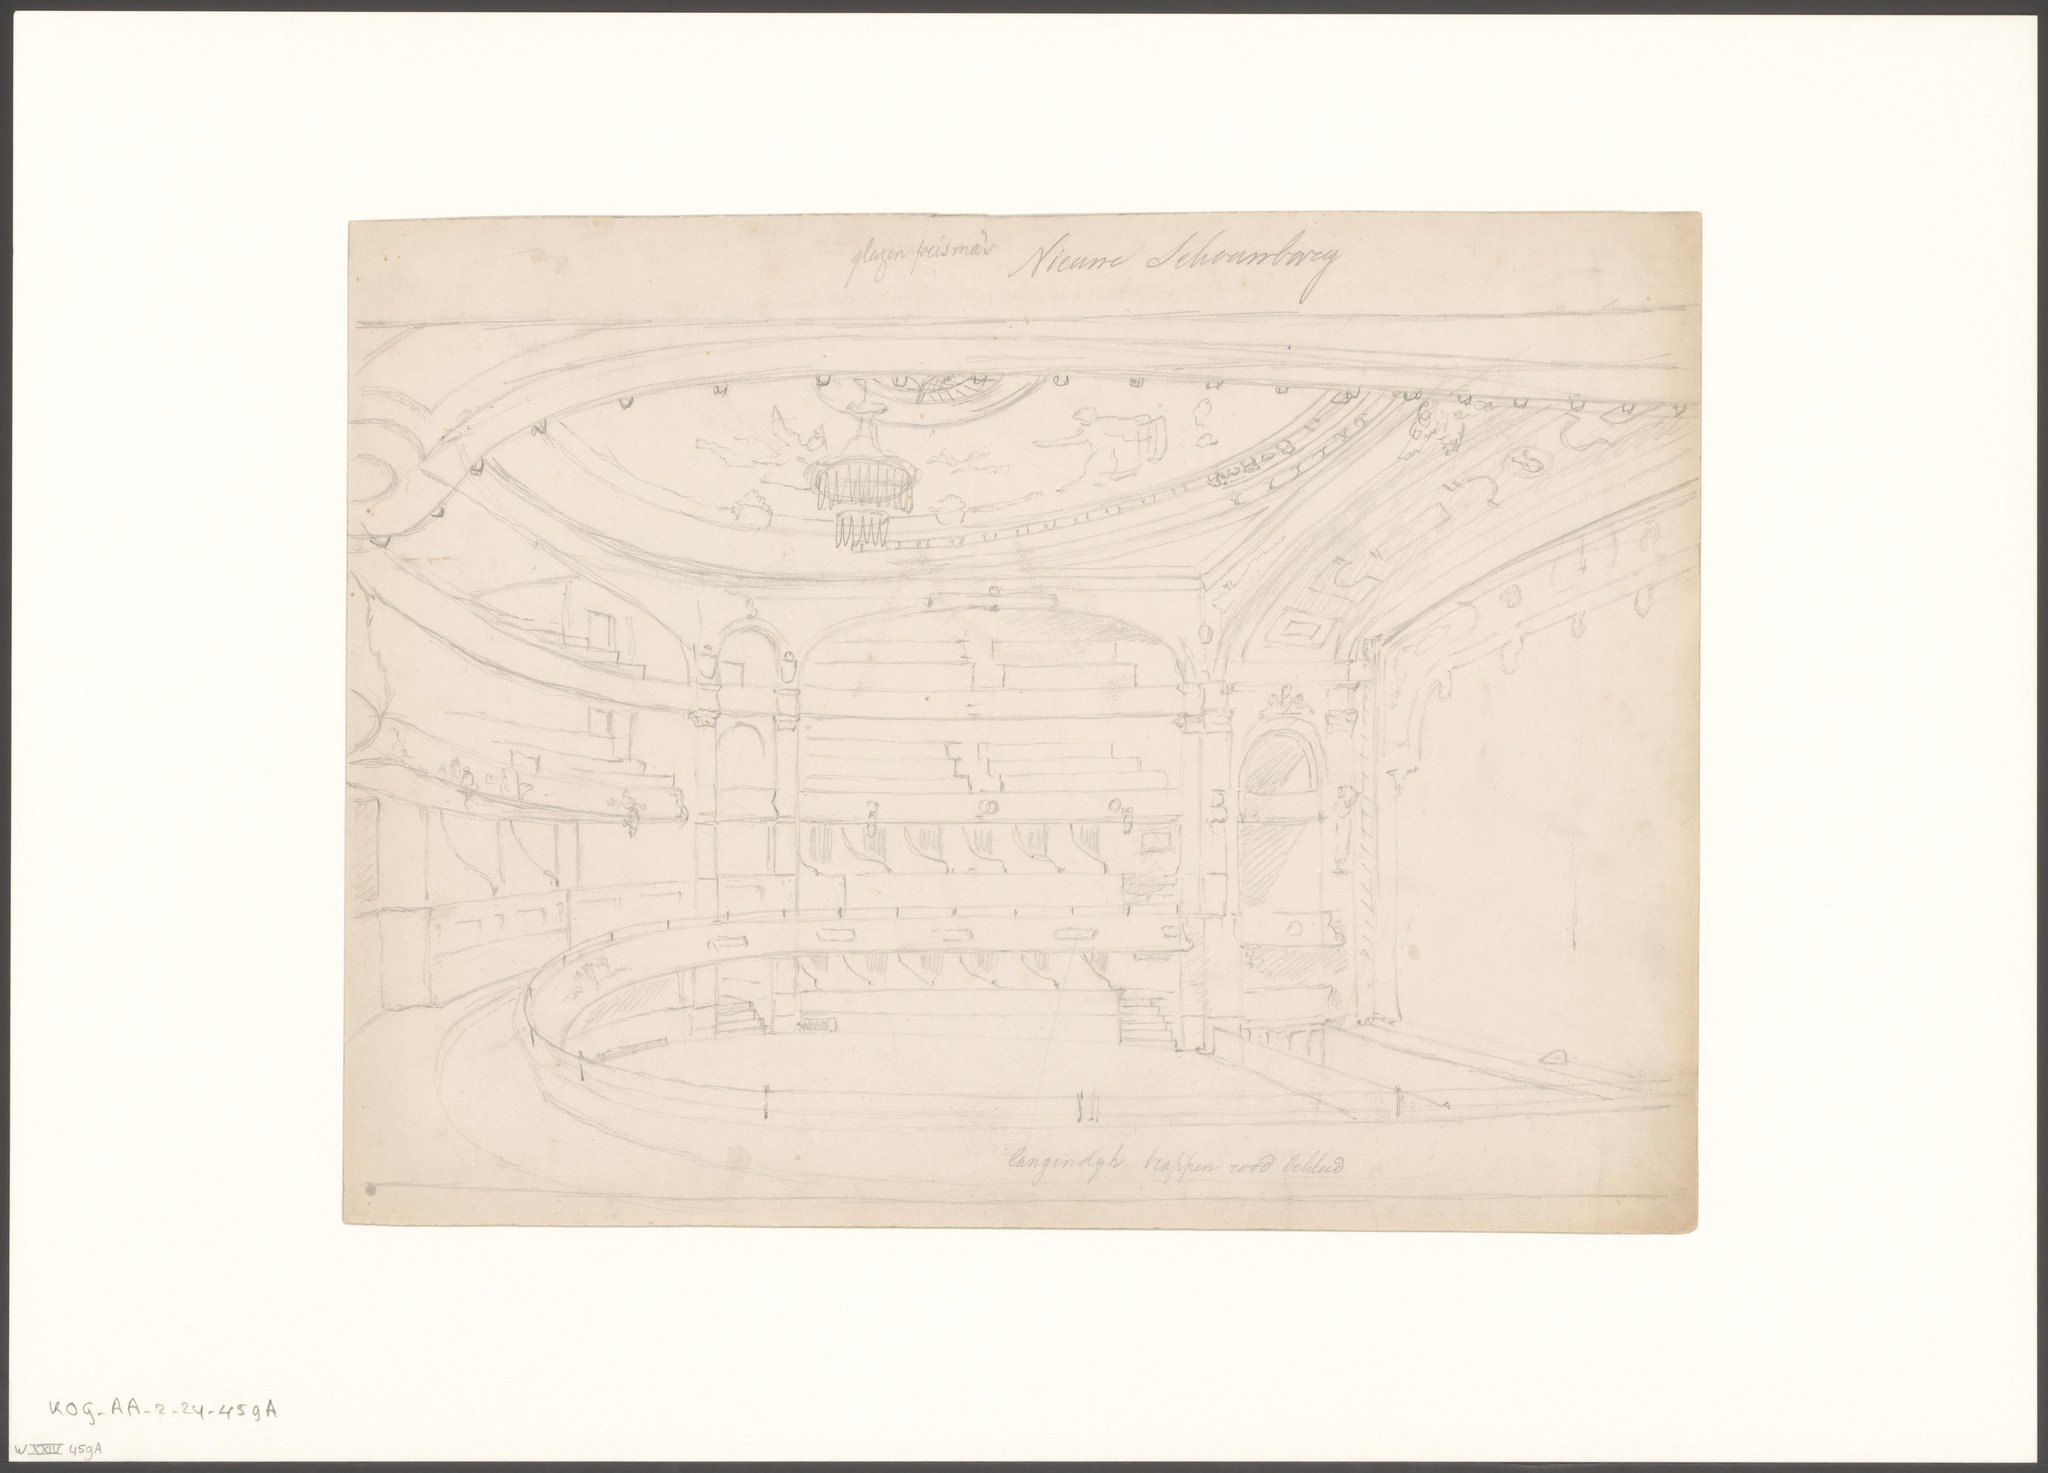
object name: drawing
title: Interieur van de zaal van de Stadsschouwburg aan het Leidseplein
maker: johan george lodewijk rieke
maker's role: draughtsman, print maker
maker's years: 1817-1898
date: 1827-1890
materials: paper, pencil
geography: amsterdam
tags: theatre (building), the stage and its equipment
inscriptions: inscription: ‘glazen prisma's Nieuwe Schouwburg / langendijk trappen rood bekleed’, inscription: ‘binnen in het (...) roode rozen lie[...]’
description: Tekening binnen de Atlas Van Eck ingedeeld op wijknummer 24.